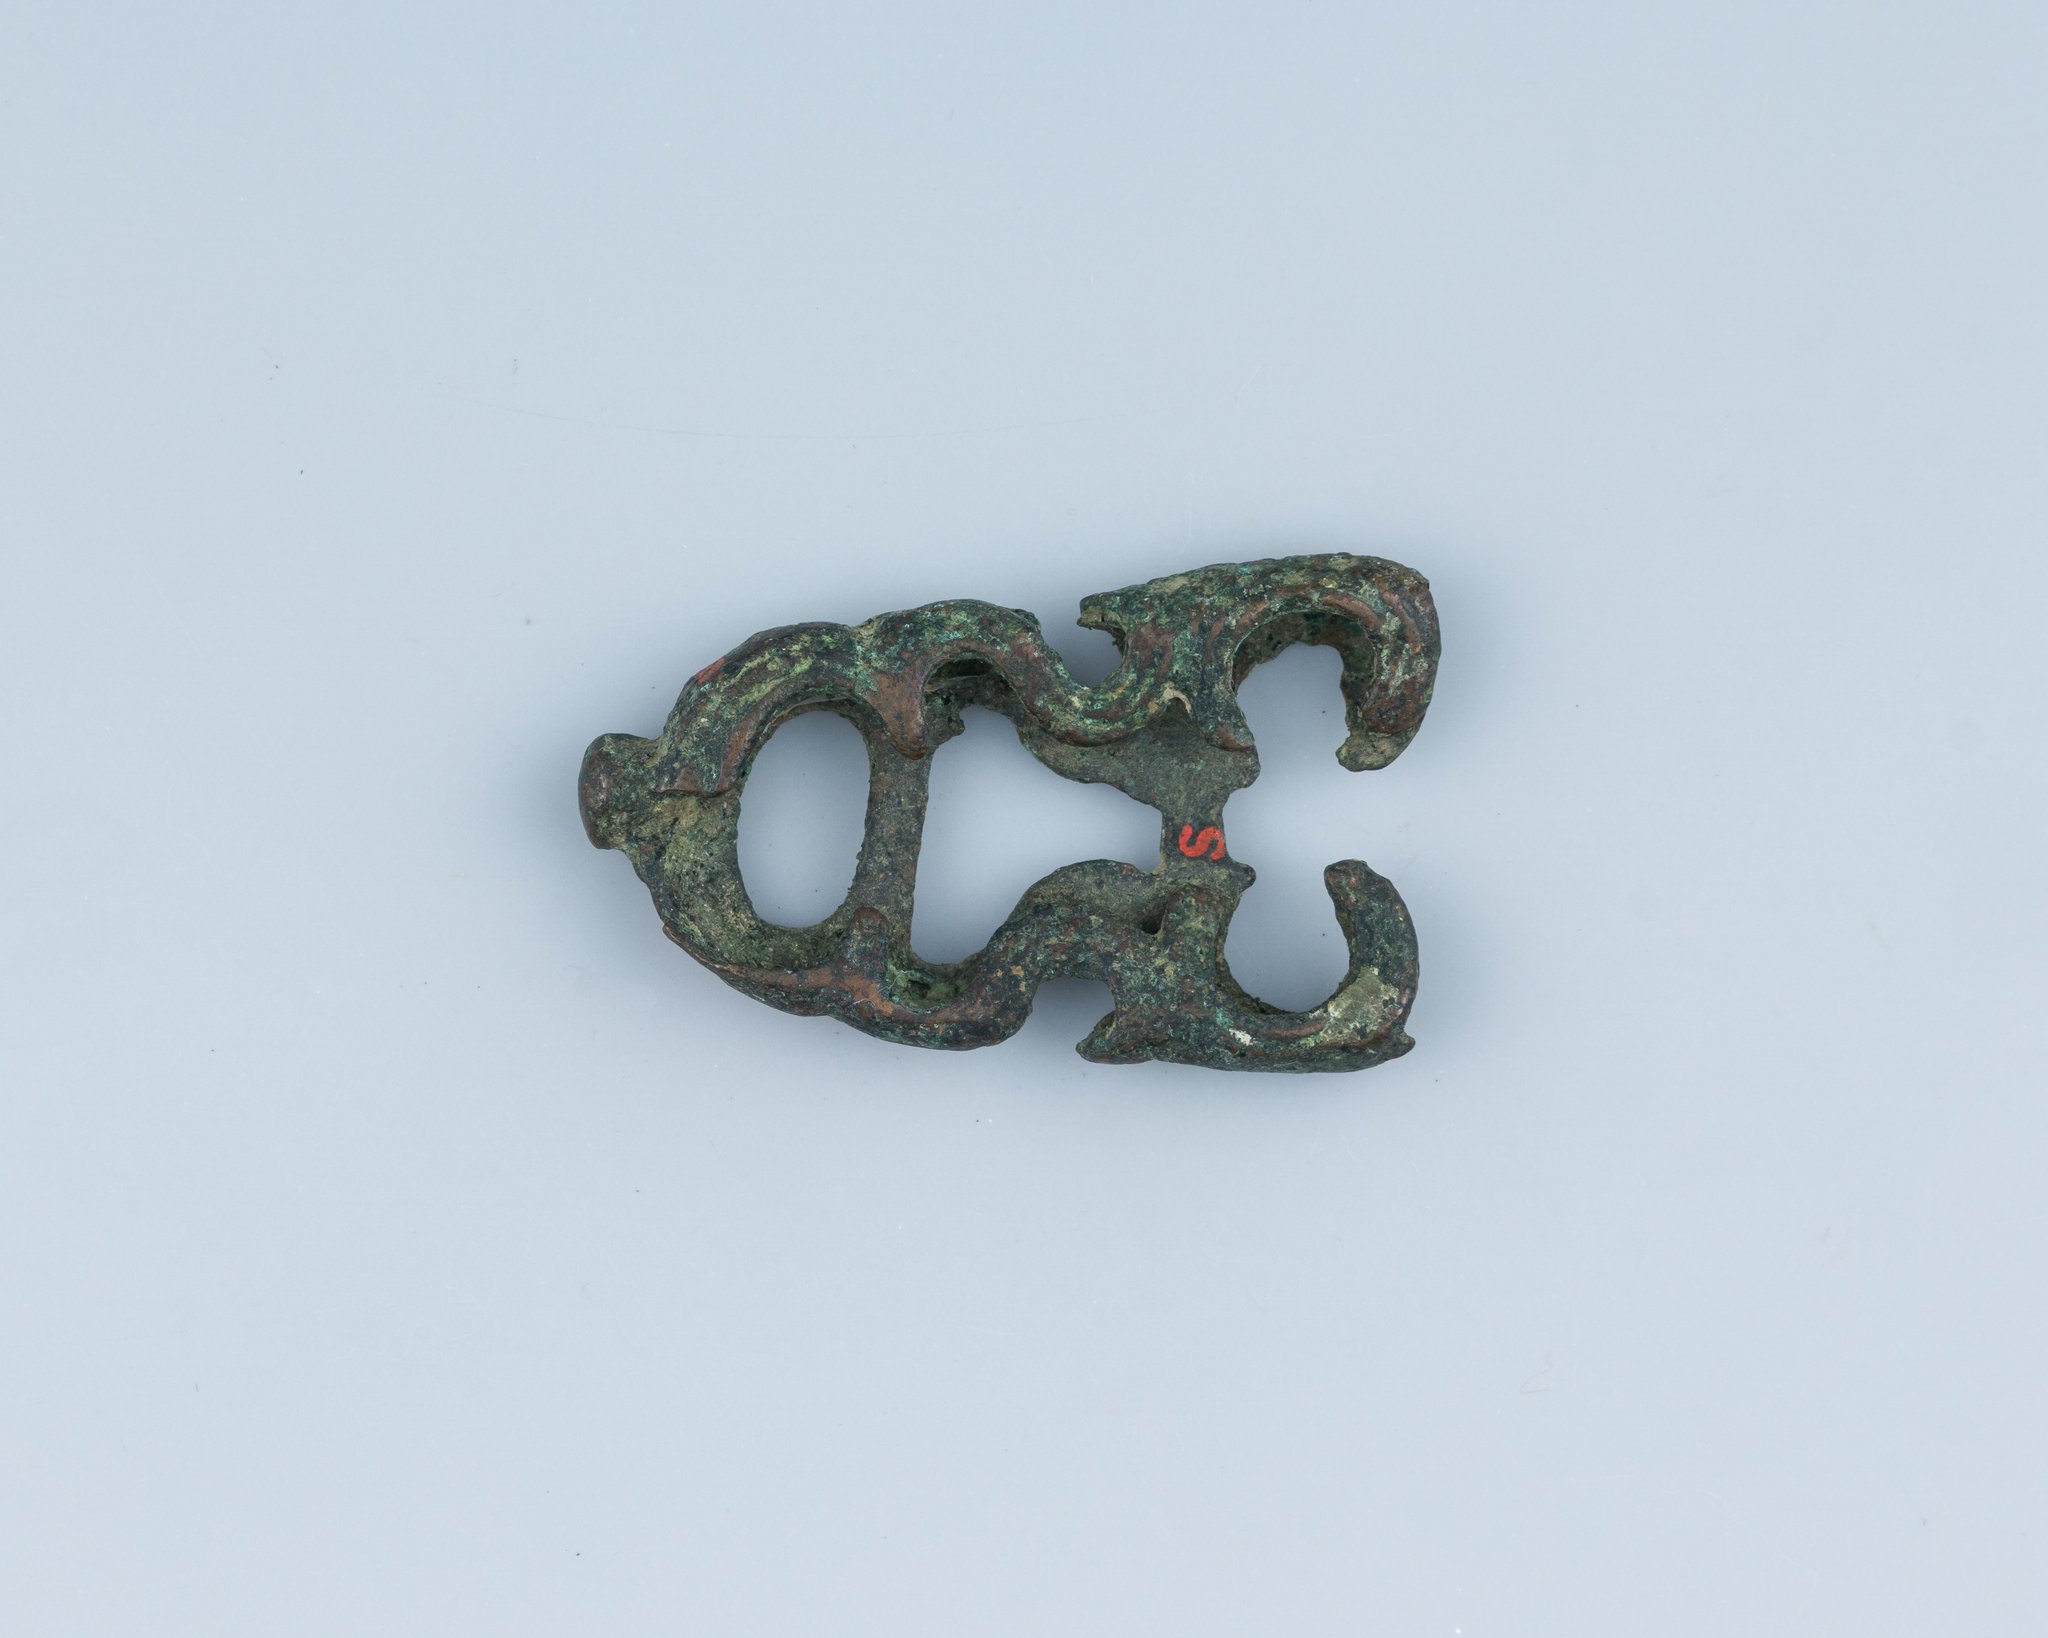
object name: mordant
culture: european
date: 1401-1700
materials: bronze